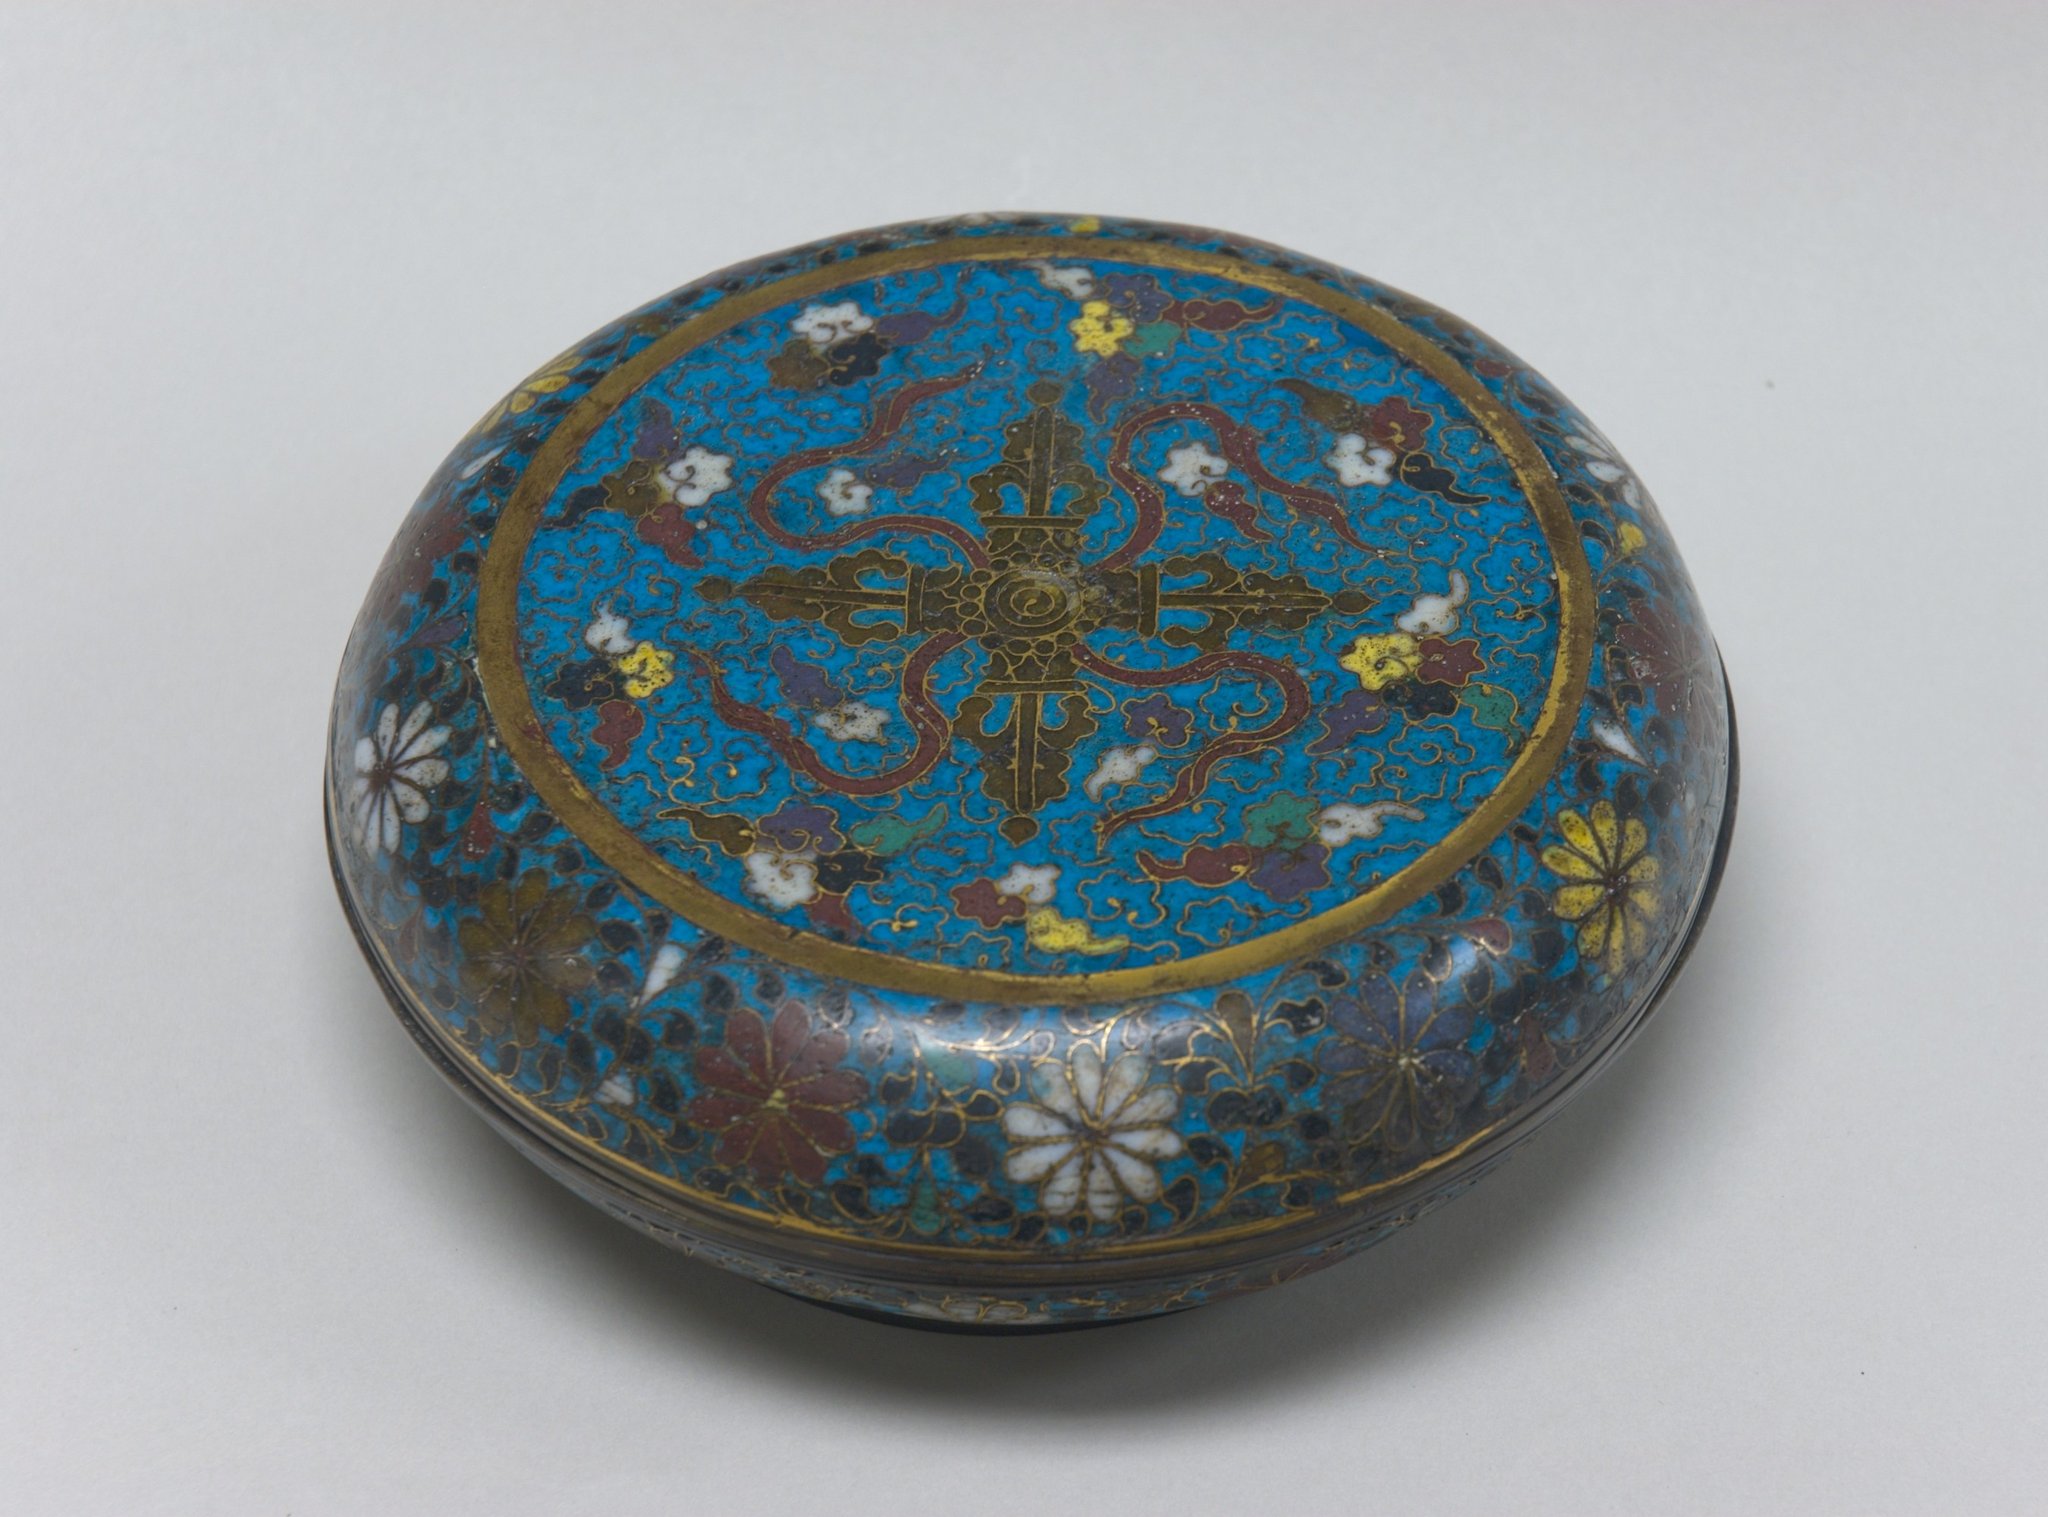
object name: covered box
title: Covered box with vajra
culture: chinese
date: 1534-1566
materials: enamel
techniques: enamel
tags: flowers